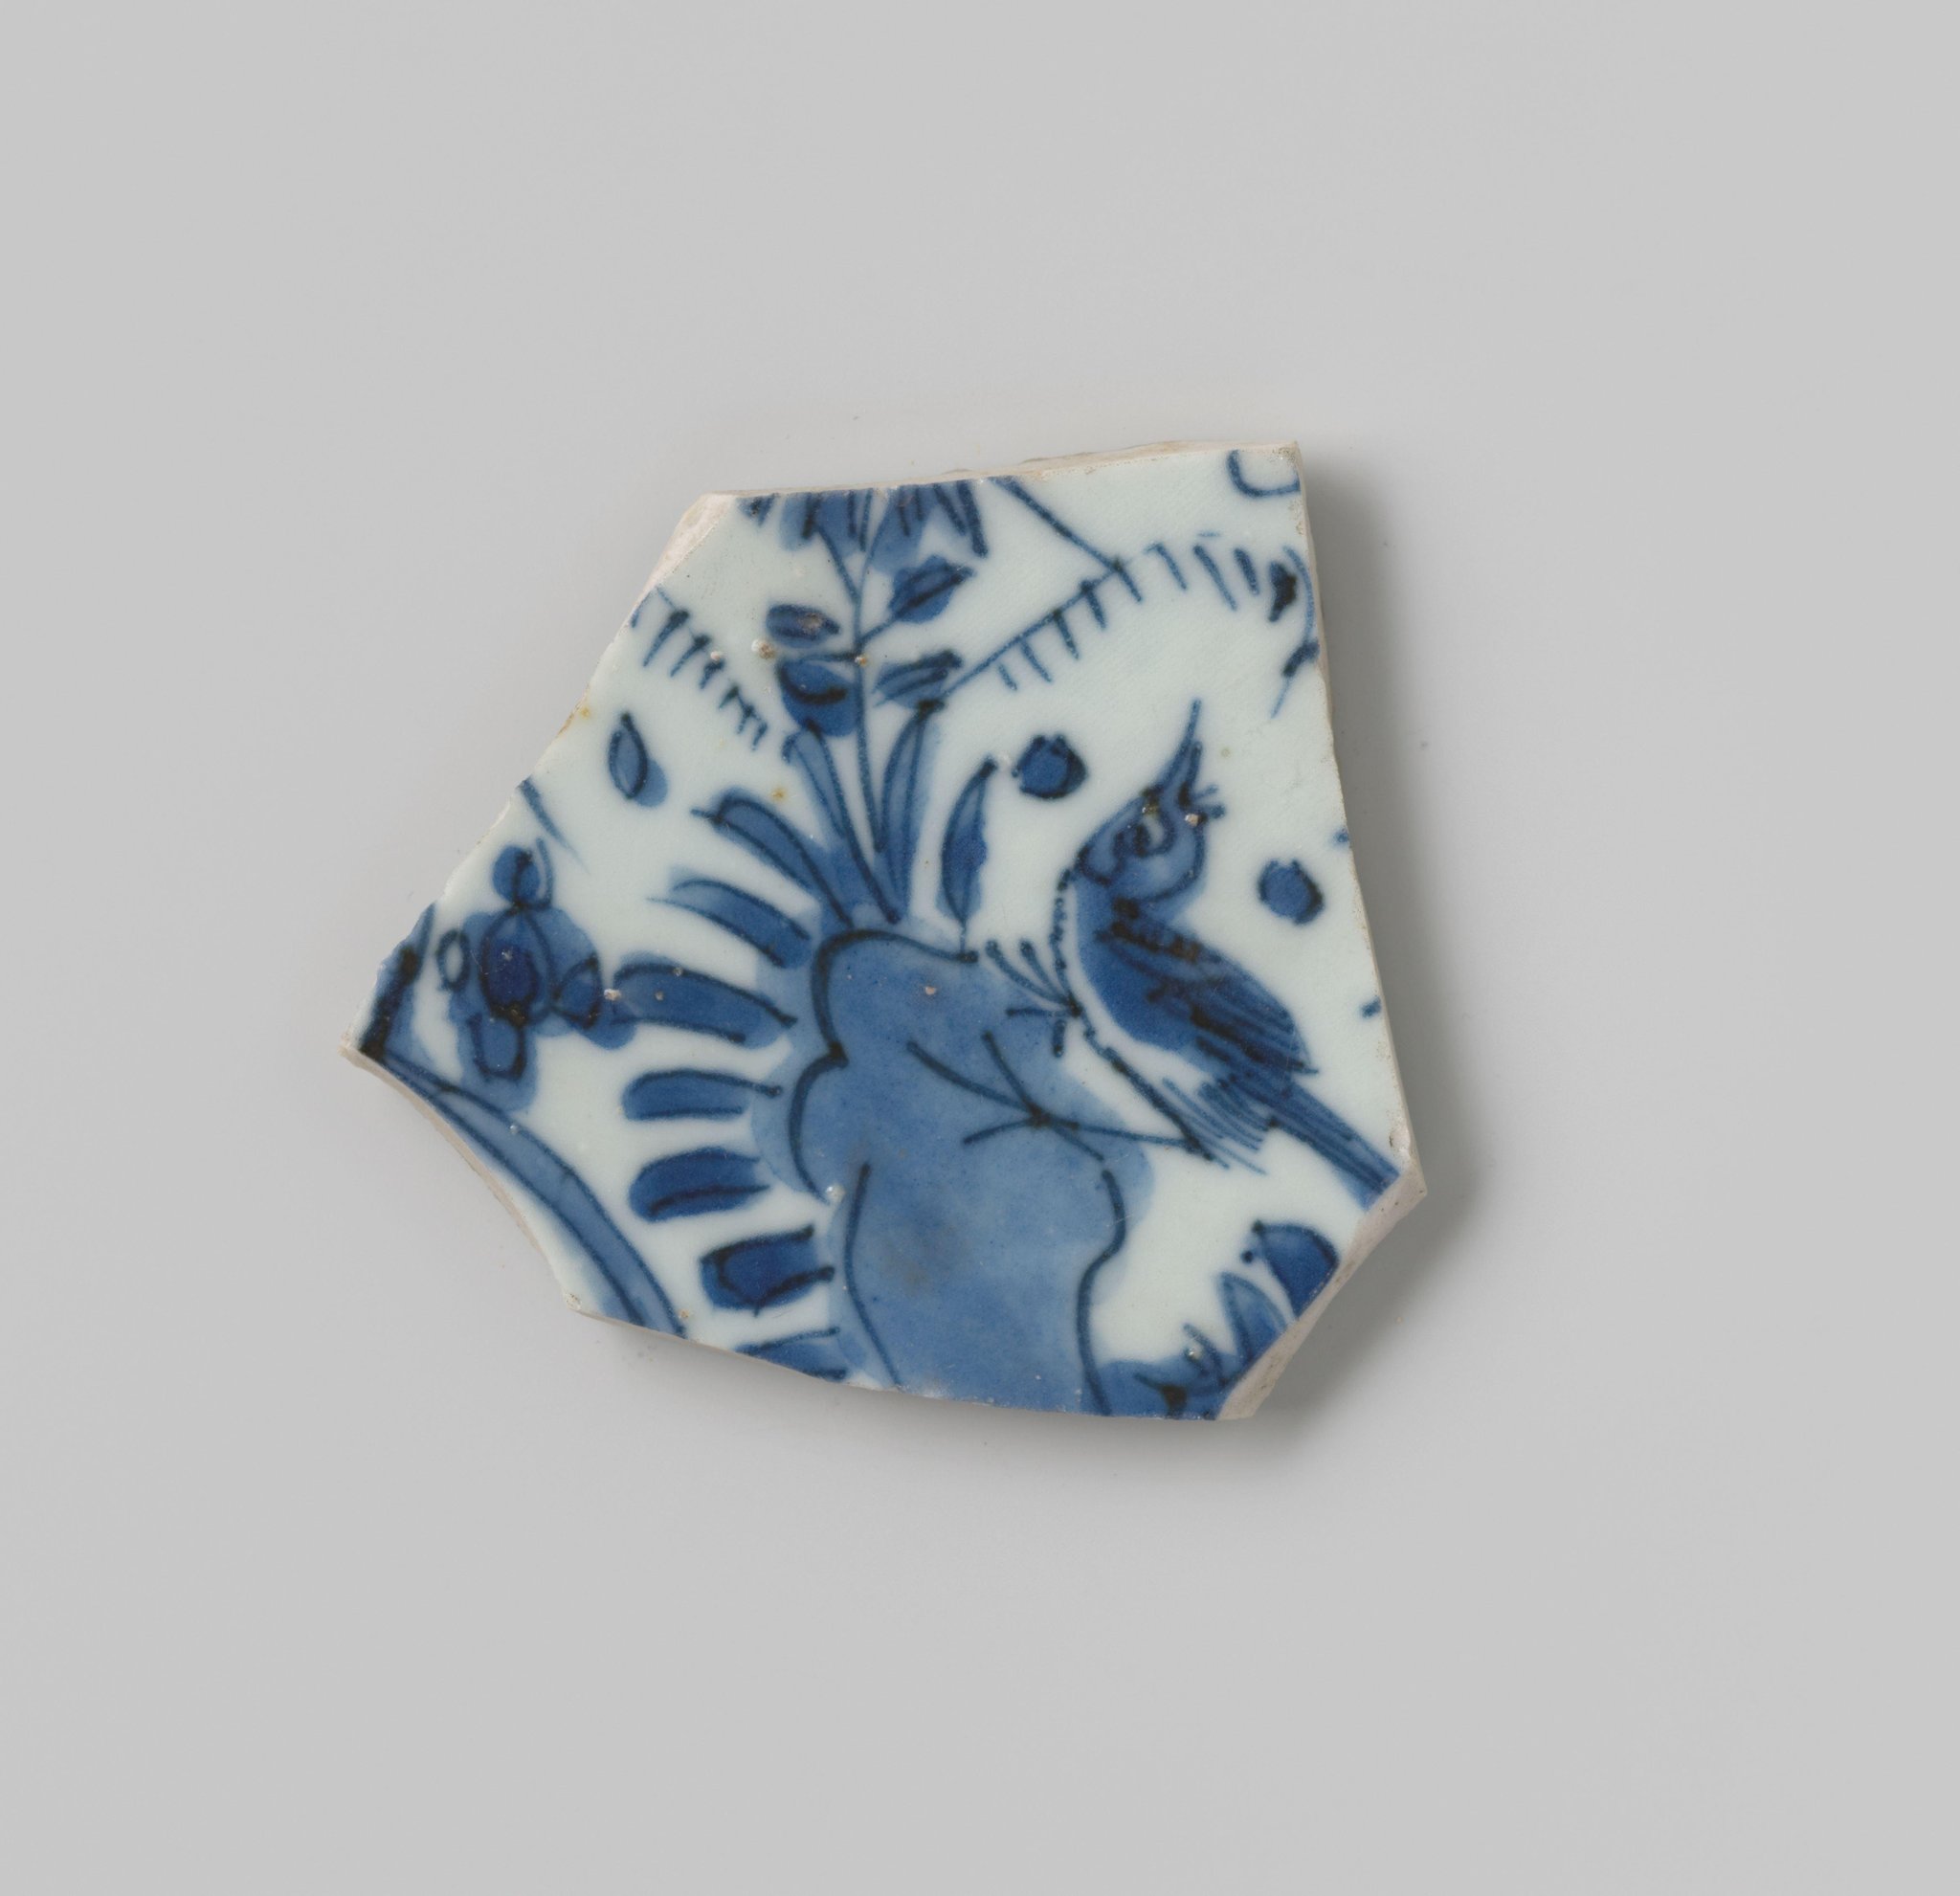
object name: sherd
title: Sherd with a bird on a rock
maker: Anonymous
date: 1600-1624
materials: cobalt, glaze, paint, porcelain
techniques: firing, turning, vitrification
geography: china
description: Schotelscherf van porselein, voorzien van een schildering van planten en een vogel in blauw aan de voorzijde en van kleurloze glazuur aan de voor- en achterzijde